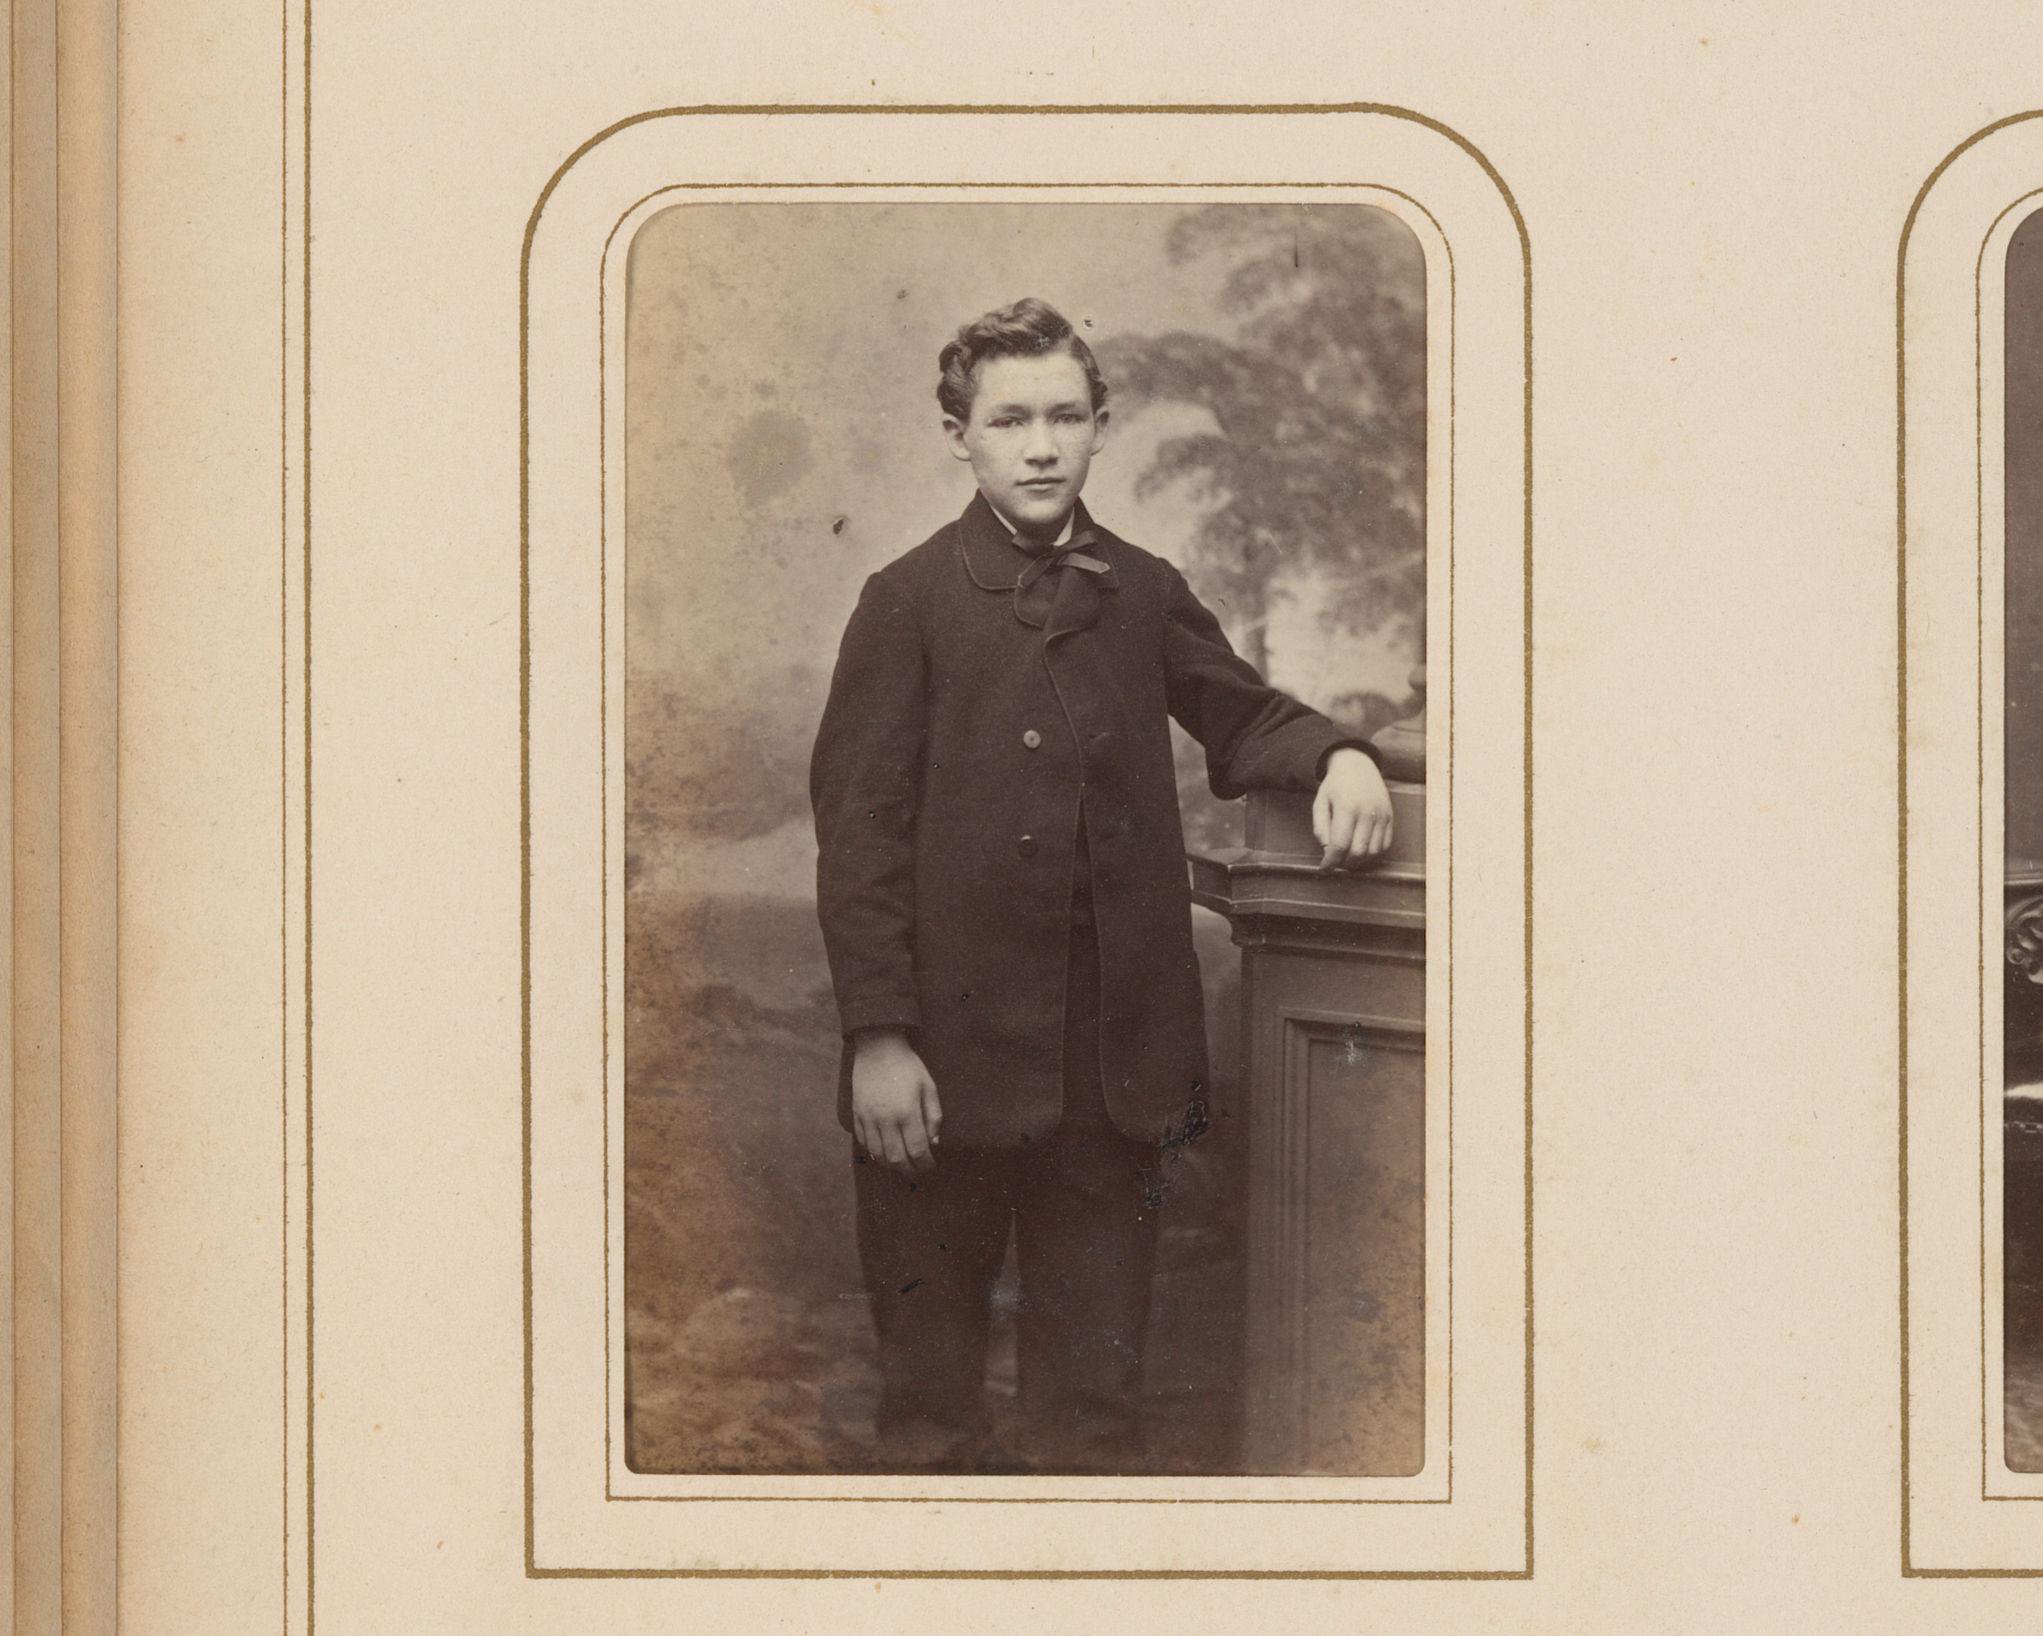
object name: photograph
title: Portret van een jongen, mogelijk Hellmuth Ulrici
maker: albert greiner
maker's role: fotograaf, fotostudio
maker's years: 1833-1890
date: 1861-1874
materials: cardboard, photographic support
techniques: albumen print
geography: amsterdam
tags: berlin, boy (child between toddler and youth), historical persons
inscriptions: inscription: ‘A. Greiner/ Photograf/ NIEUWENDIJK L. 87/ AMSTERDAM.’, name: ‘Ulrici’, name: ‘H. Ulrici’